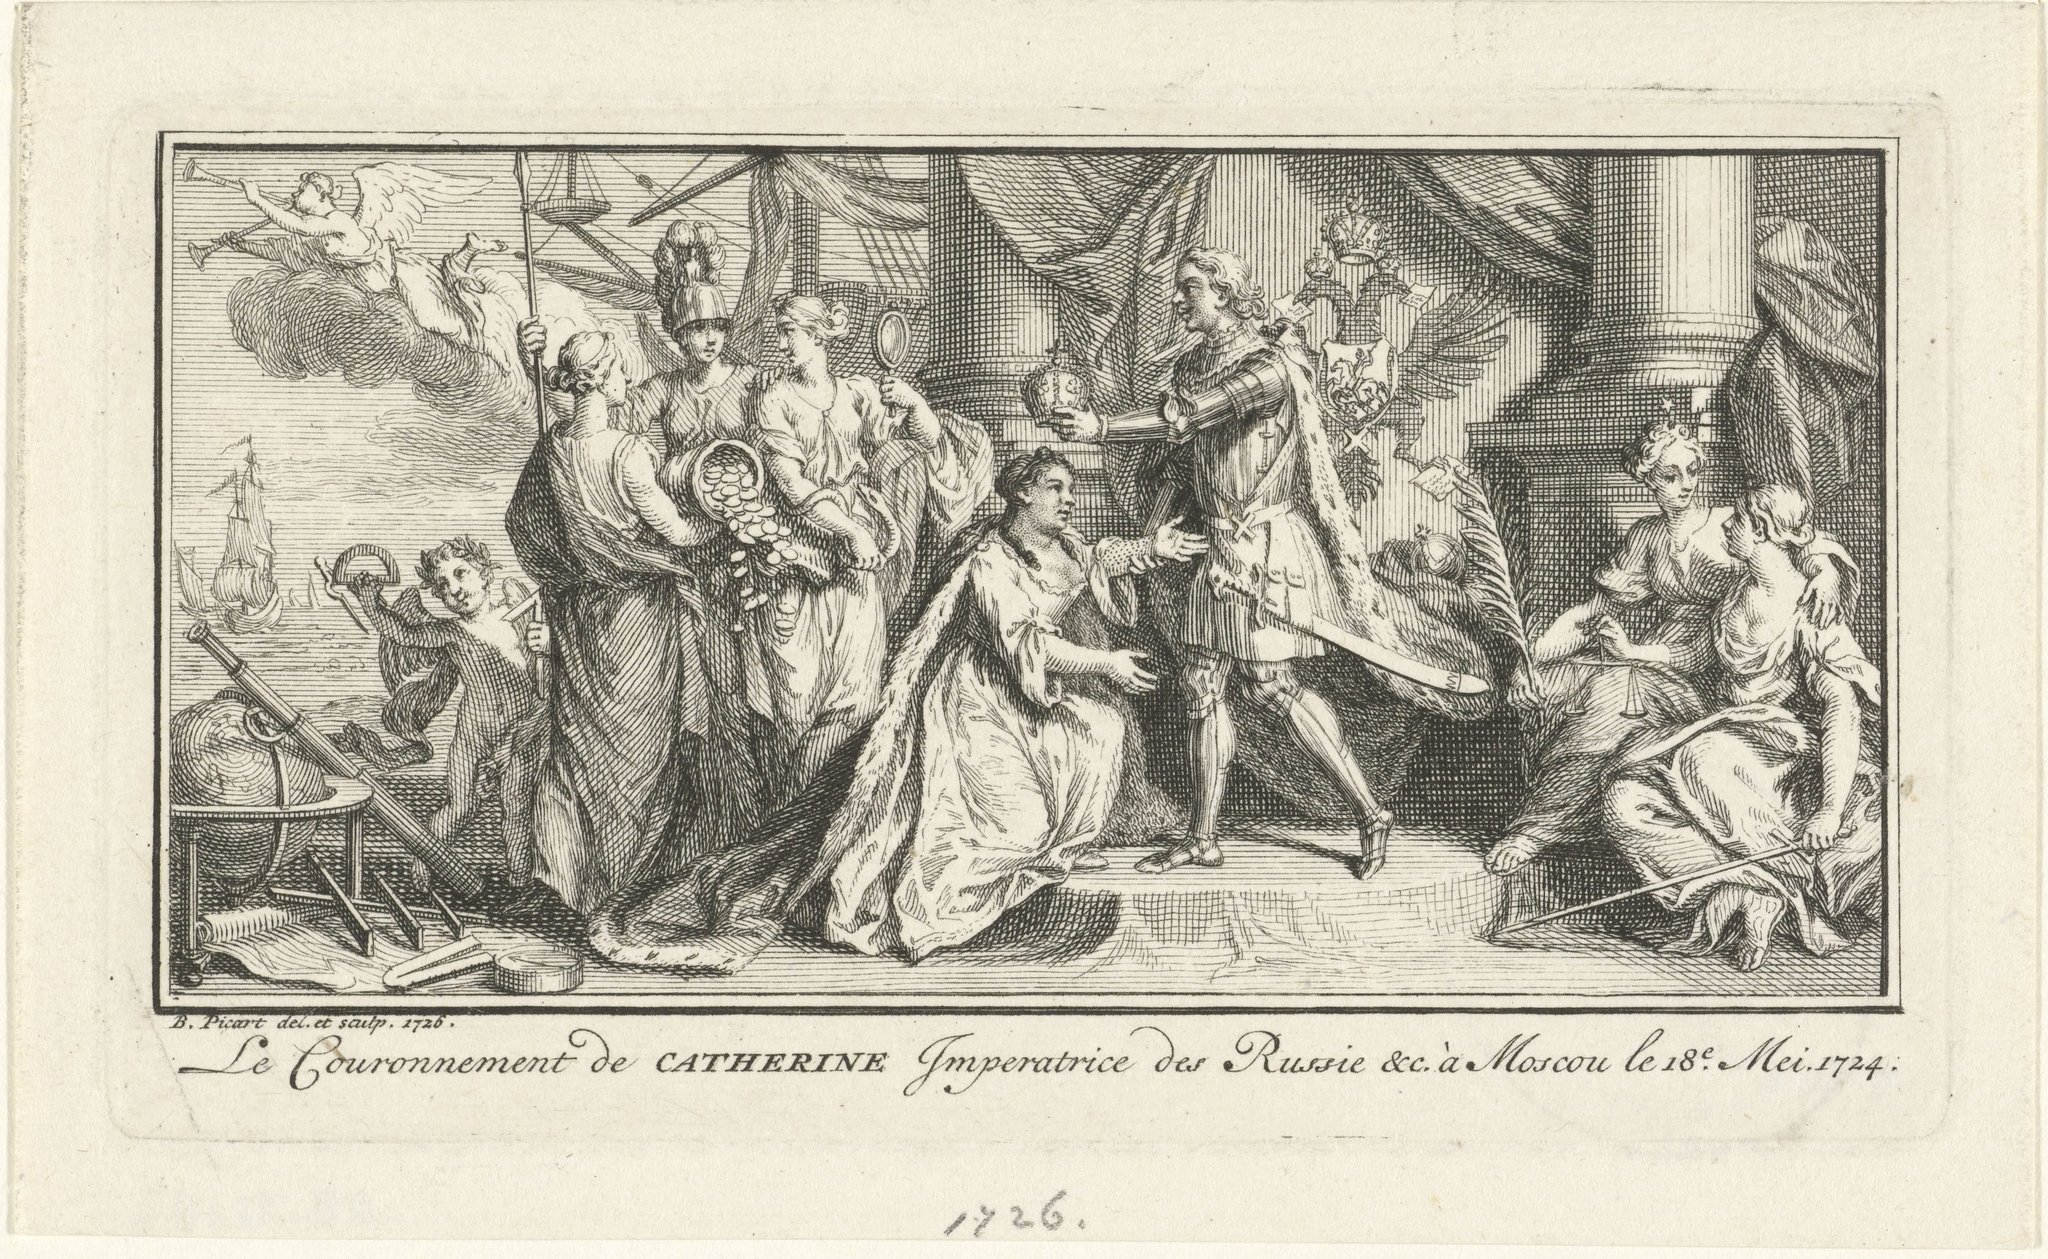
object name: print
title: Peter I de Grote kroont Catharina tot keizerin van Rusland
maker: bernard picart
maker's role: draughtsman, print maker, publisher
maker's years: 1673-1733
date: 1726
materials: paper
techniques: engraving, etching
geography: amsterdam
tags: peter i de grote (tsaar van rusland), justice, 'justitia'; 'giustitia divina' (ripa) ~ one of the four cardinal virtues, prudence, 'prudentia'; 'prudenza' (ripa) ~ one of the four cardinal virtues, (story of) minerva (pallas, athena), abundance; 'abondanza', 'abondanza maritima' (ripa), crown (symbol of sovereignty) - bb - female ruler, pier, quay, wharf, urania (one of the muses); 'urania' (ripa), fame; 'fama', 'fama buona', 'fama chiara' (ripa)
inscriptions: collector's mark: Lugt 240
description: Catharina knielt voor haar echtgenoot Peter I de Grote. Hij kroont haar op 18 mei 1724 tot keizerin. Ze worden omringd door allerlei personificaties. Links Overvloed en Voorzichtigheid bij Minerva. Rechts Rechtvaardigheid en Urania, de muze van de astronomie. Linksboven Faam die de bazuin blaast. In de marge een onderschrift in het Frans.